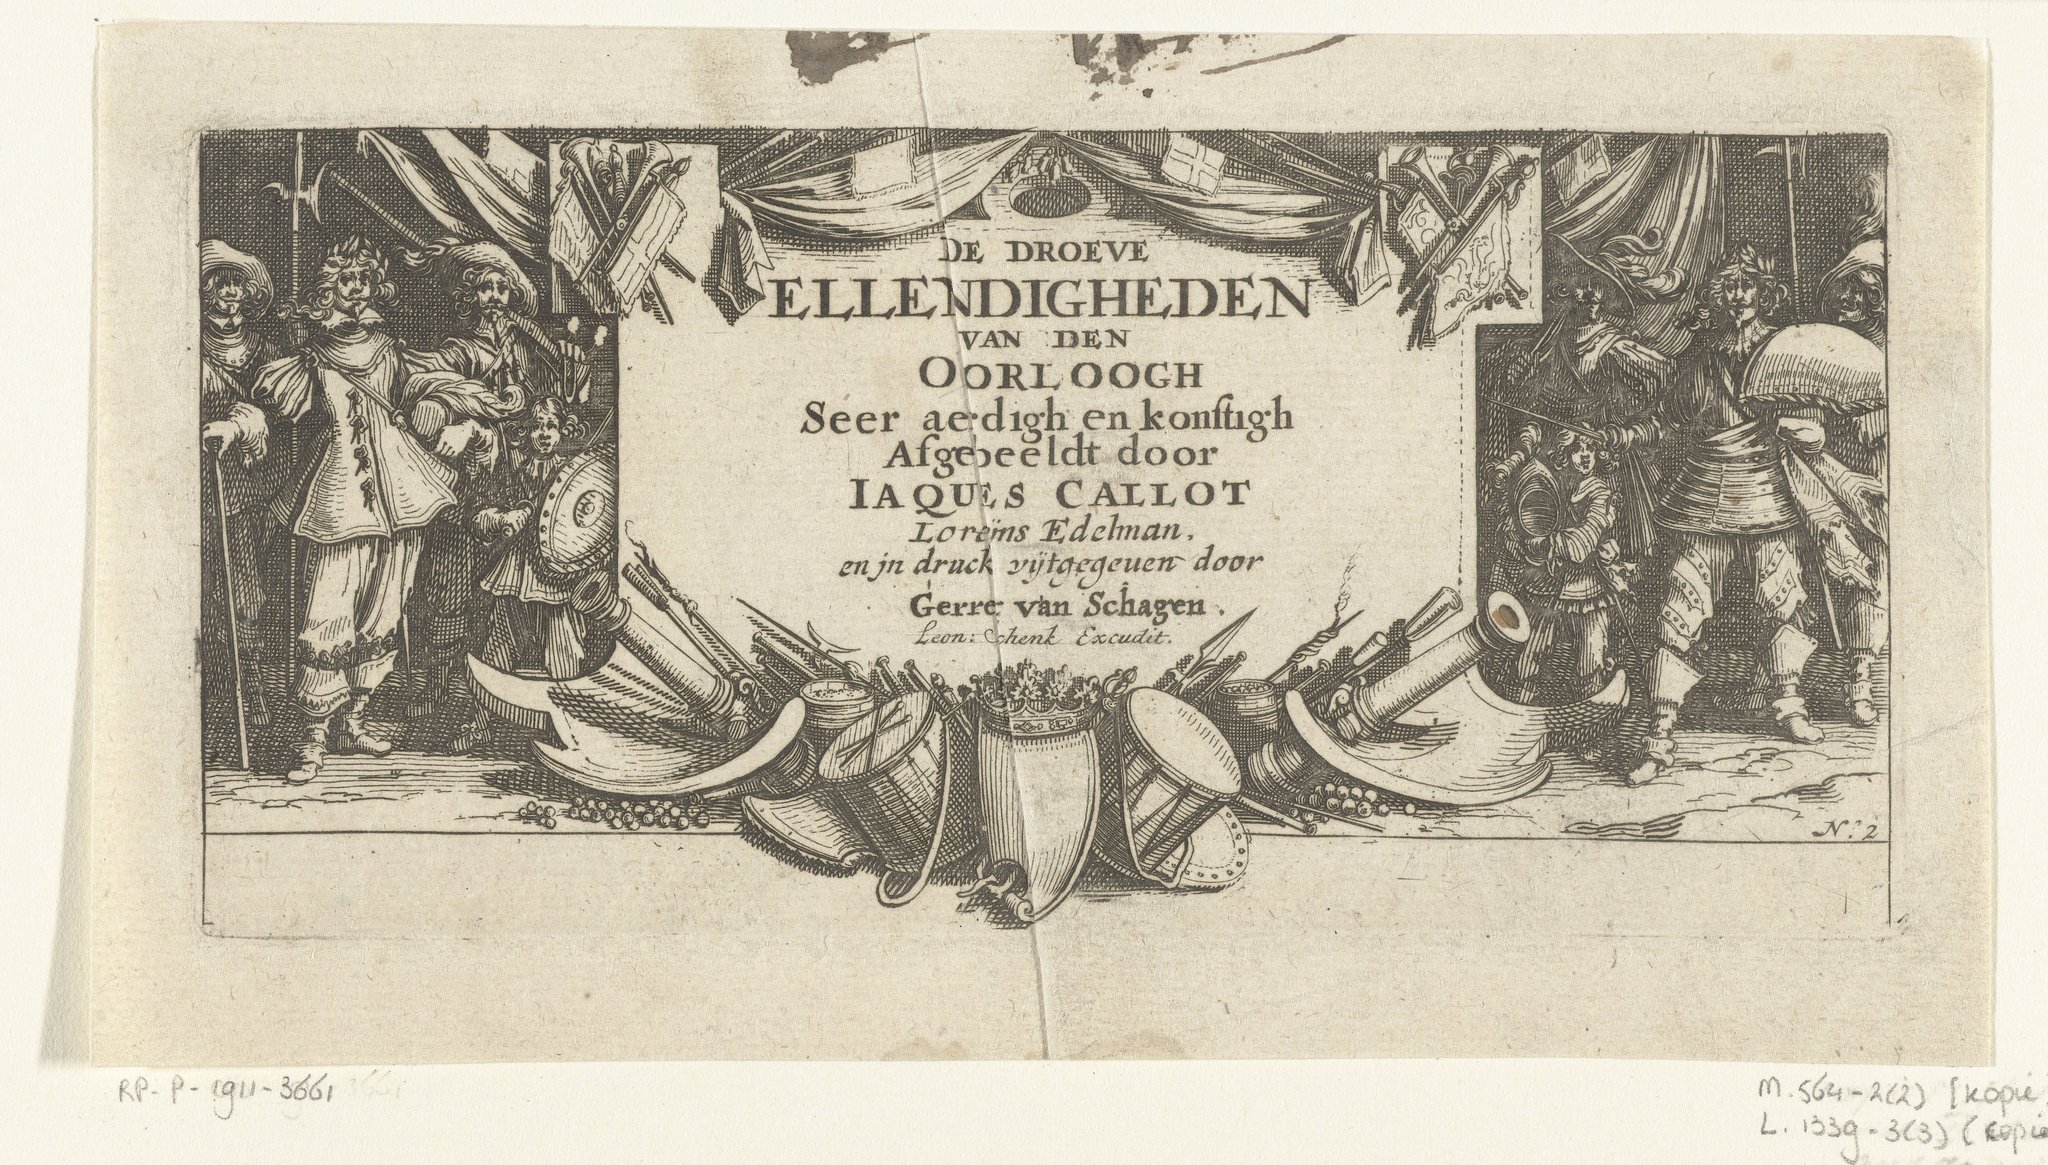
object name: titelprent, frontispice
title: De gruwelen van de oorlog (groot)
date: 1677-1690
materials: paper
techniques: etching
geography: amsterdam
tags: crown (symbol of sovereignty), drum (musical instrument), weapons, firearms: cannon, officer, ornament ~ cartouche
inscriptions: collector's mark: Lugt 2228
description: Nederlandse tekst in cartouche in de vorm van een groot tablet. Op de voorgrond wapens, kogels, trommels en een kroon. Aan weerszijden van het tablet soldaten. Onder de voorstelling een lege marge. Dit is de titelprent voor een serie van 17 prenten met voorstellingen van diverse soorten ellende die oorlogvoering met zich meebrengt.